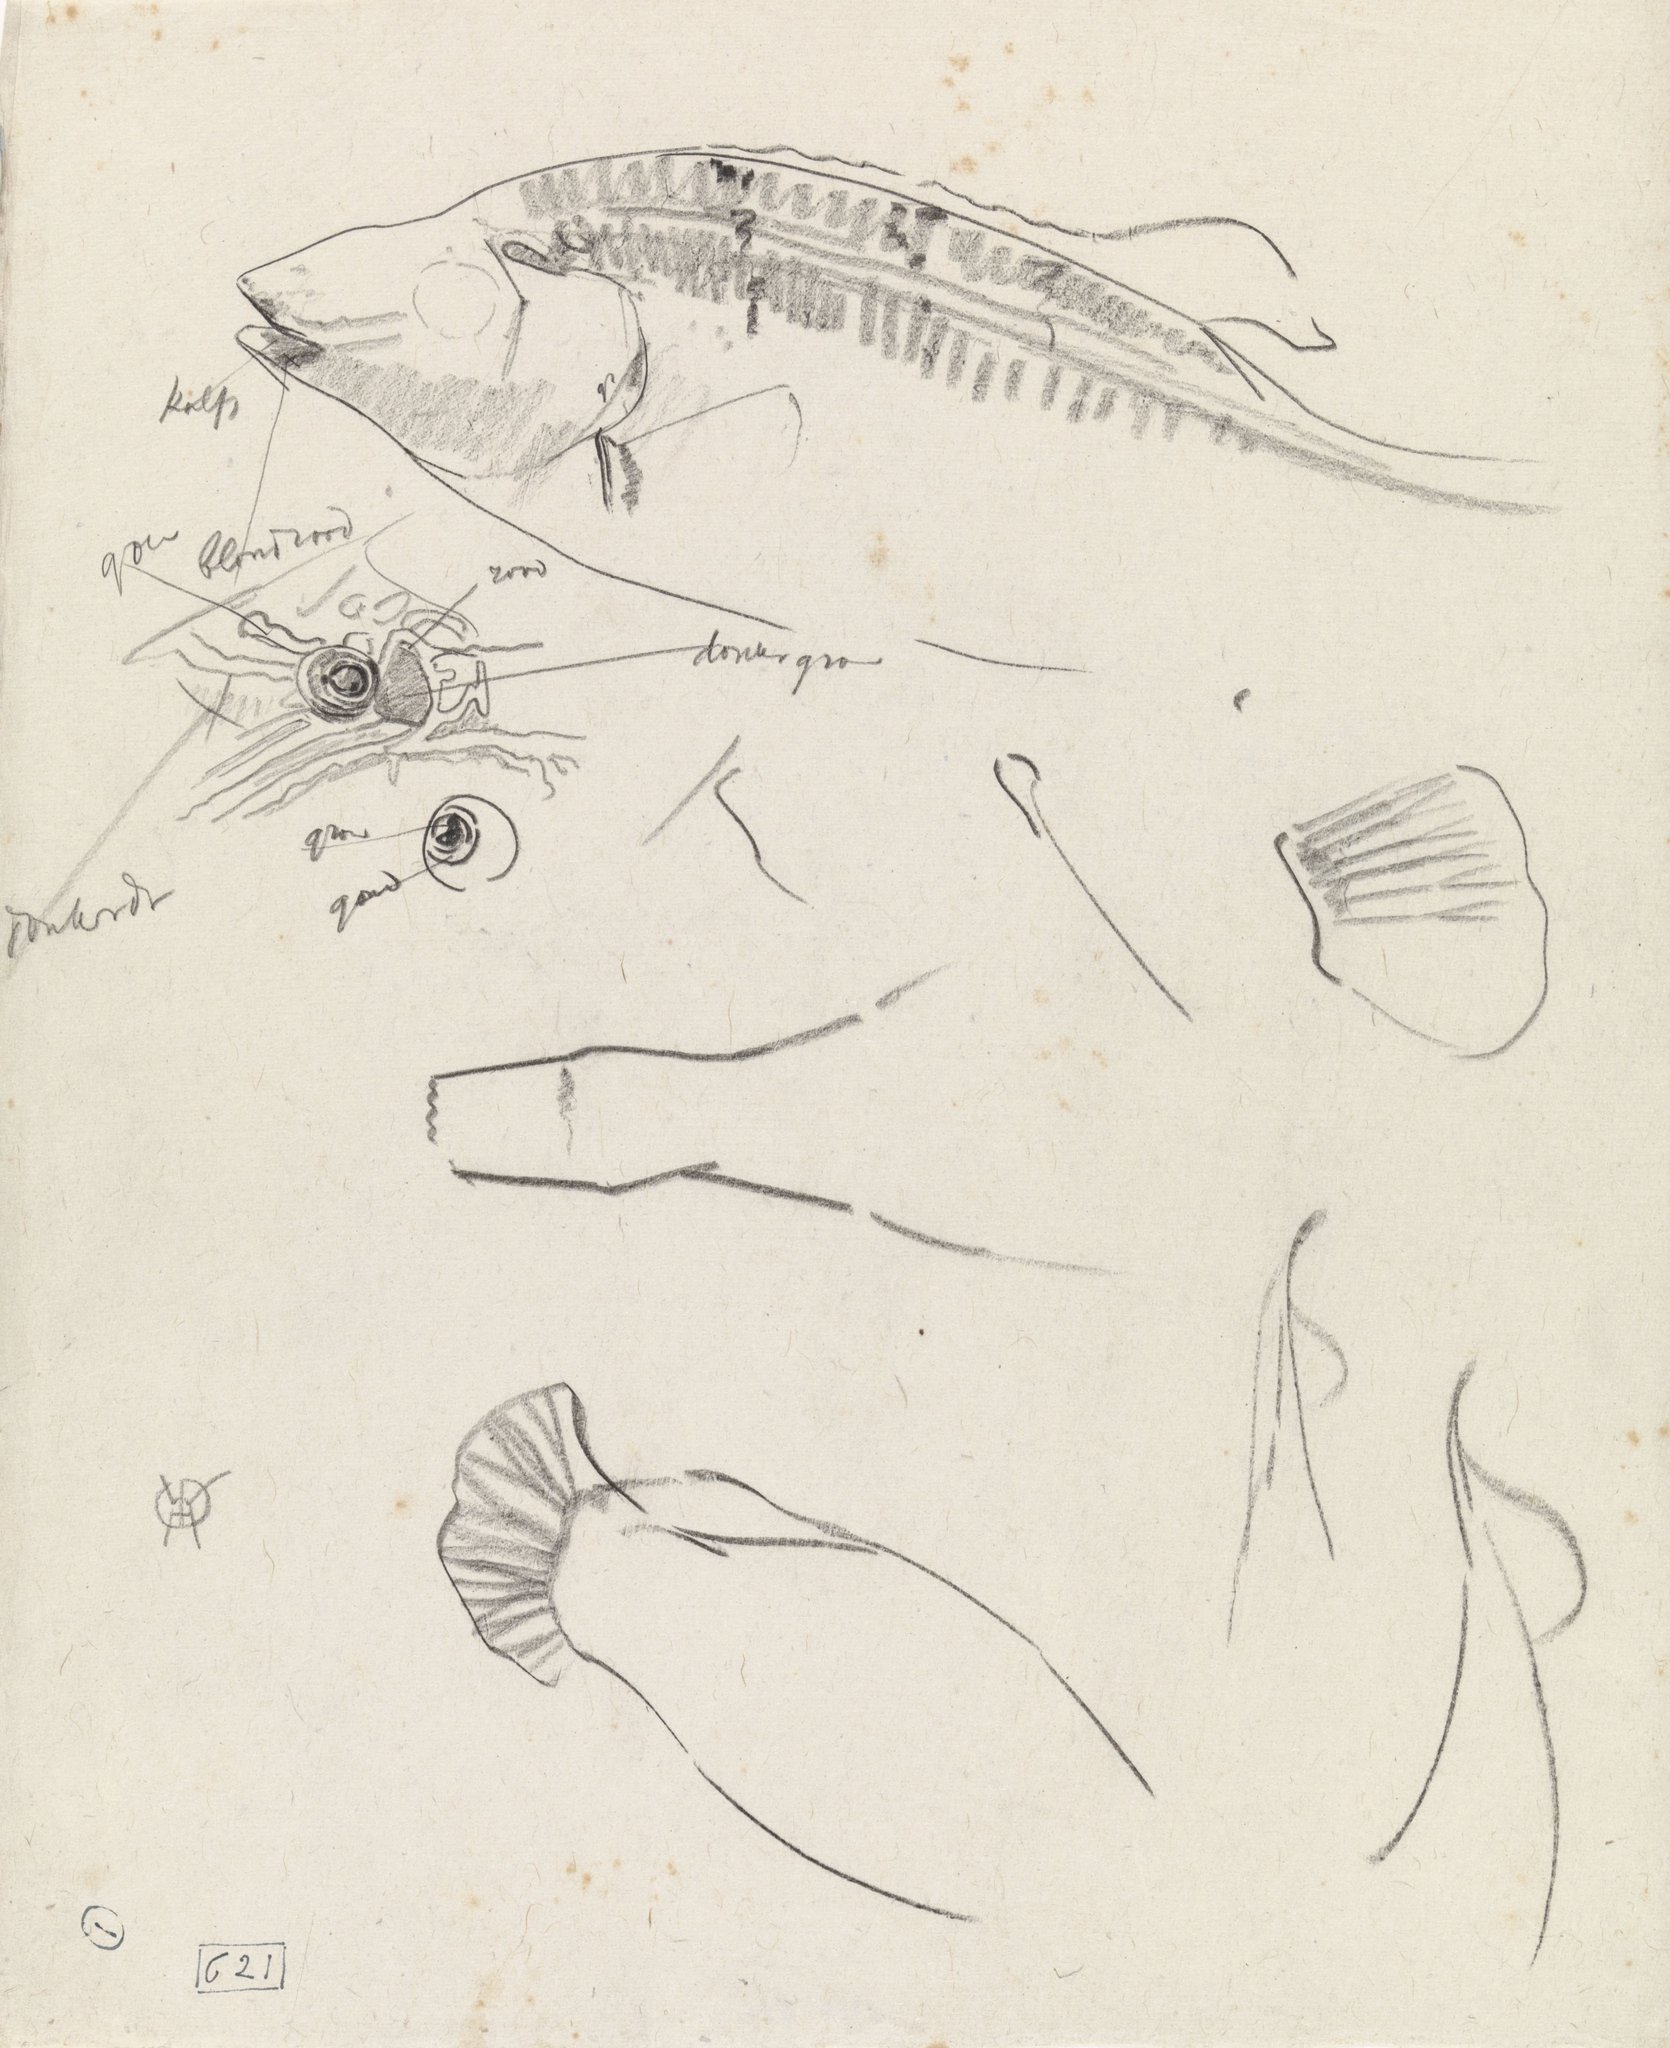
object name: drawing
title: Detailstudies van vissen, met kleurnotities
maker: gerrit willem dijsselhof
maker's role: designer, draughtsman, print maker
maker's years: 1866-1924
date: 1876-1924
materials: chalk, paper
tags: bony fishes